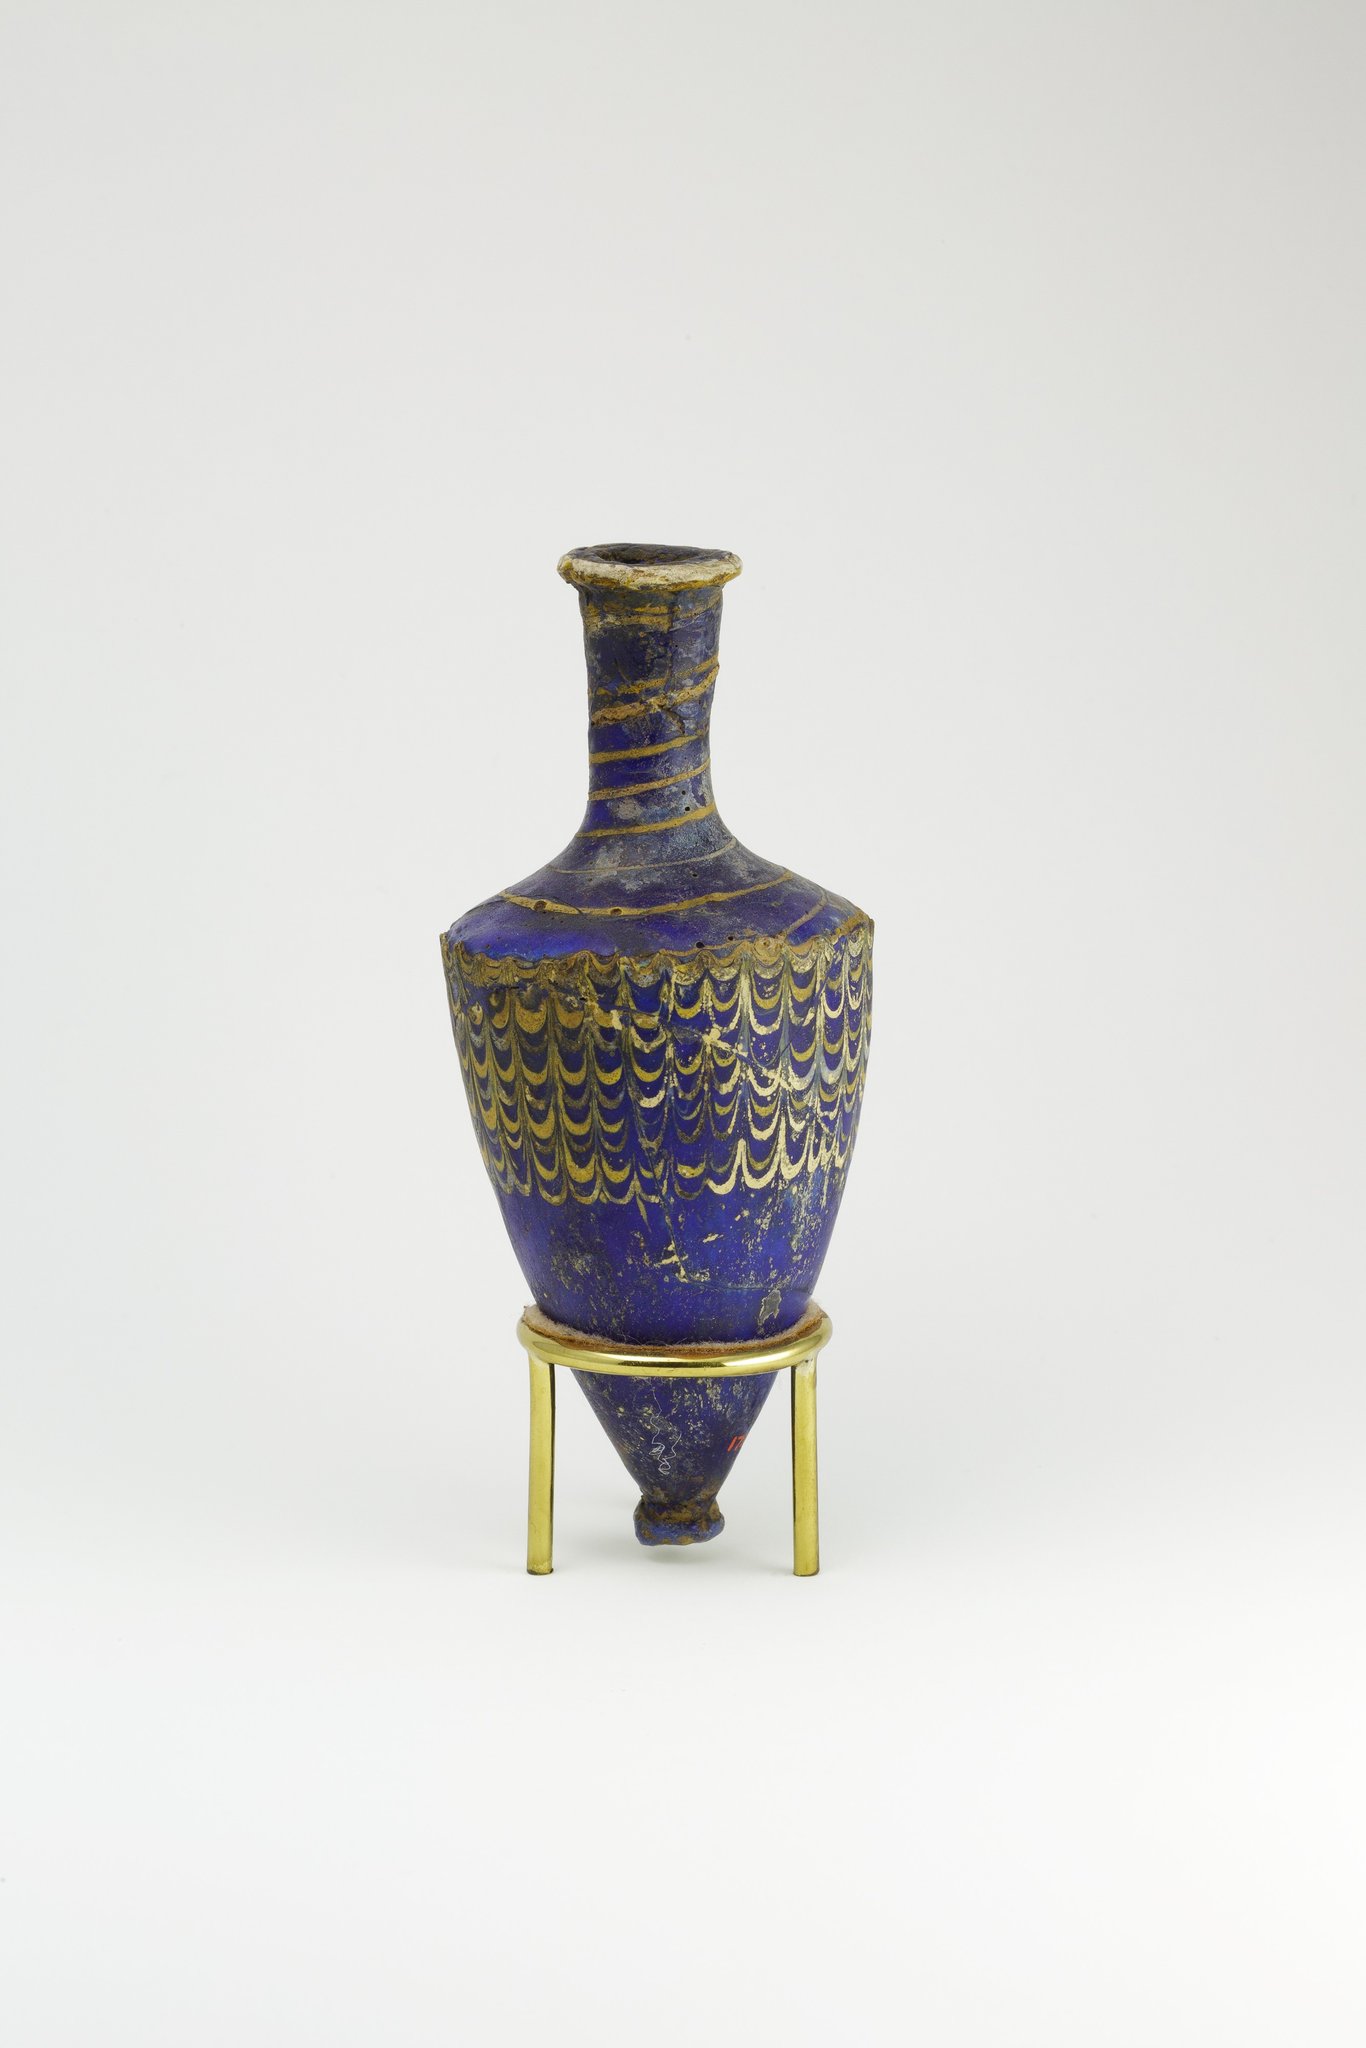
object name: perfume vase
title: Jar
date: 664-630 BCE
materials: glass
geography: egypt